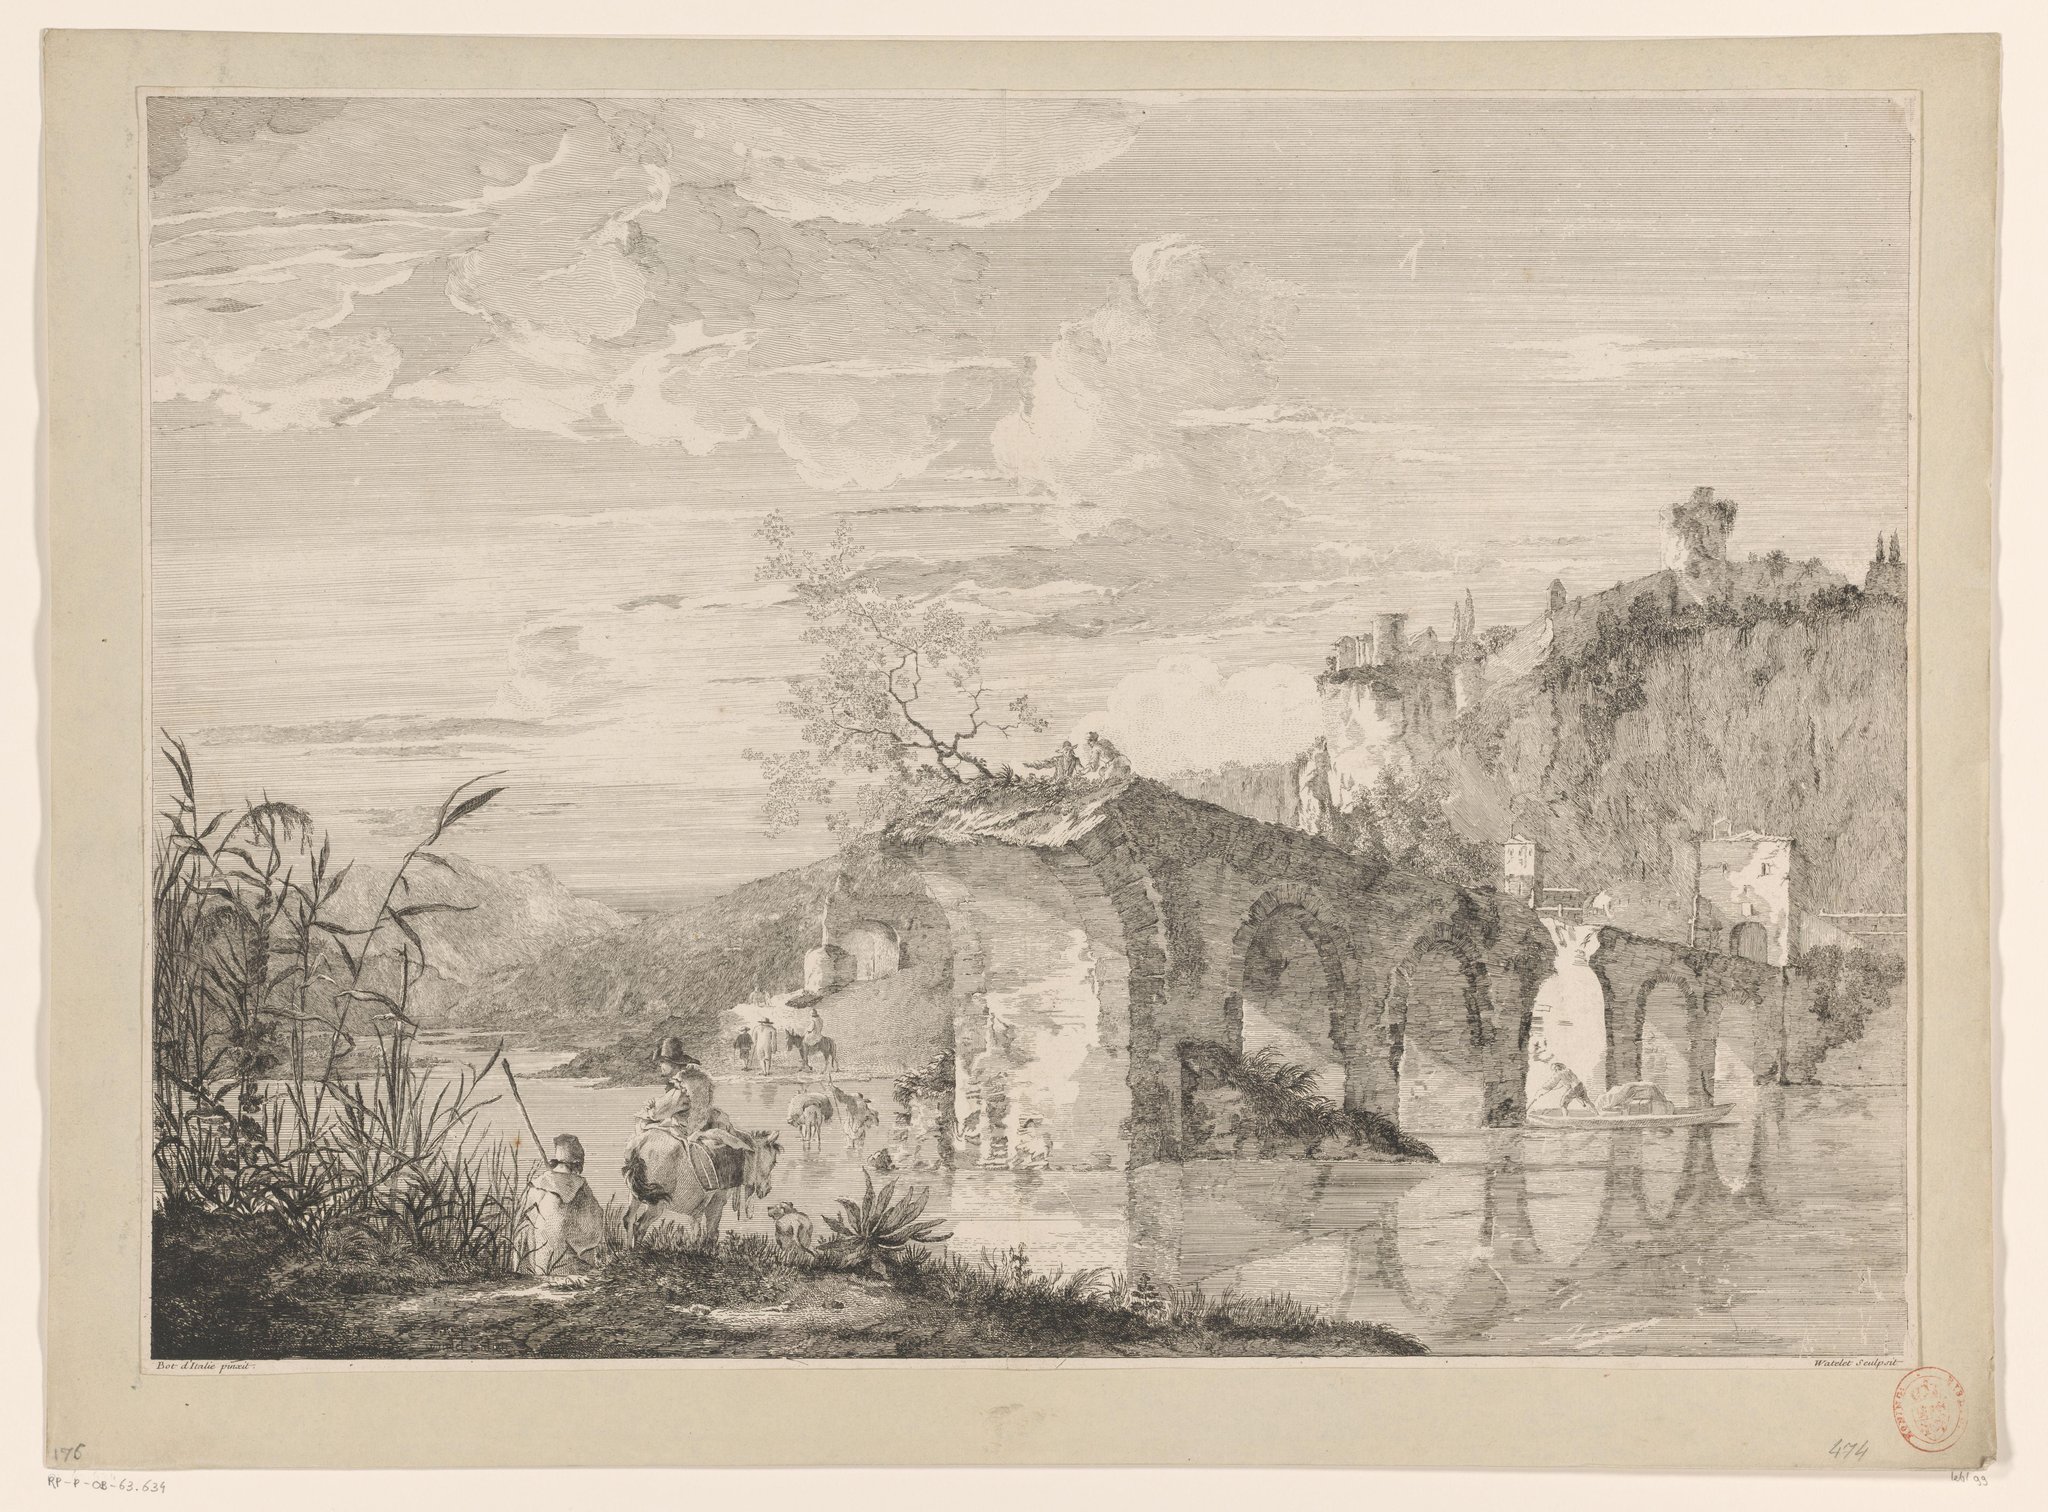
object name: print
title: Rivierlandschap met vervallen burg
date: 1728-1786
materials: paper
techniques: etching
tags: landscape with ruins, bridge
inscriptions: collector's mark: Lugt 240